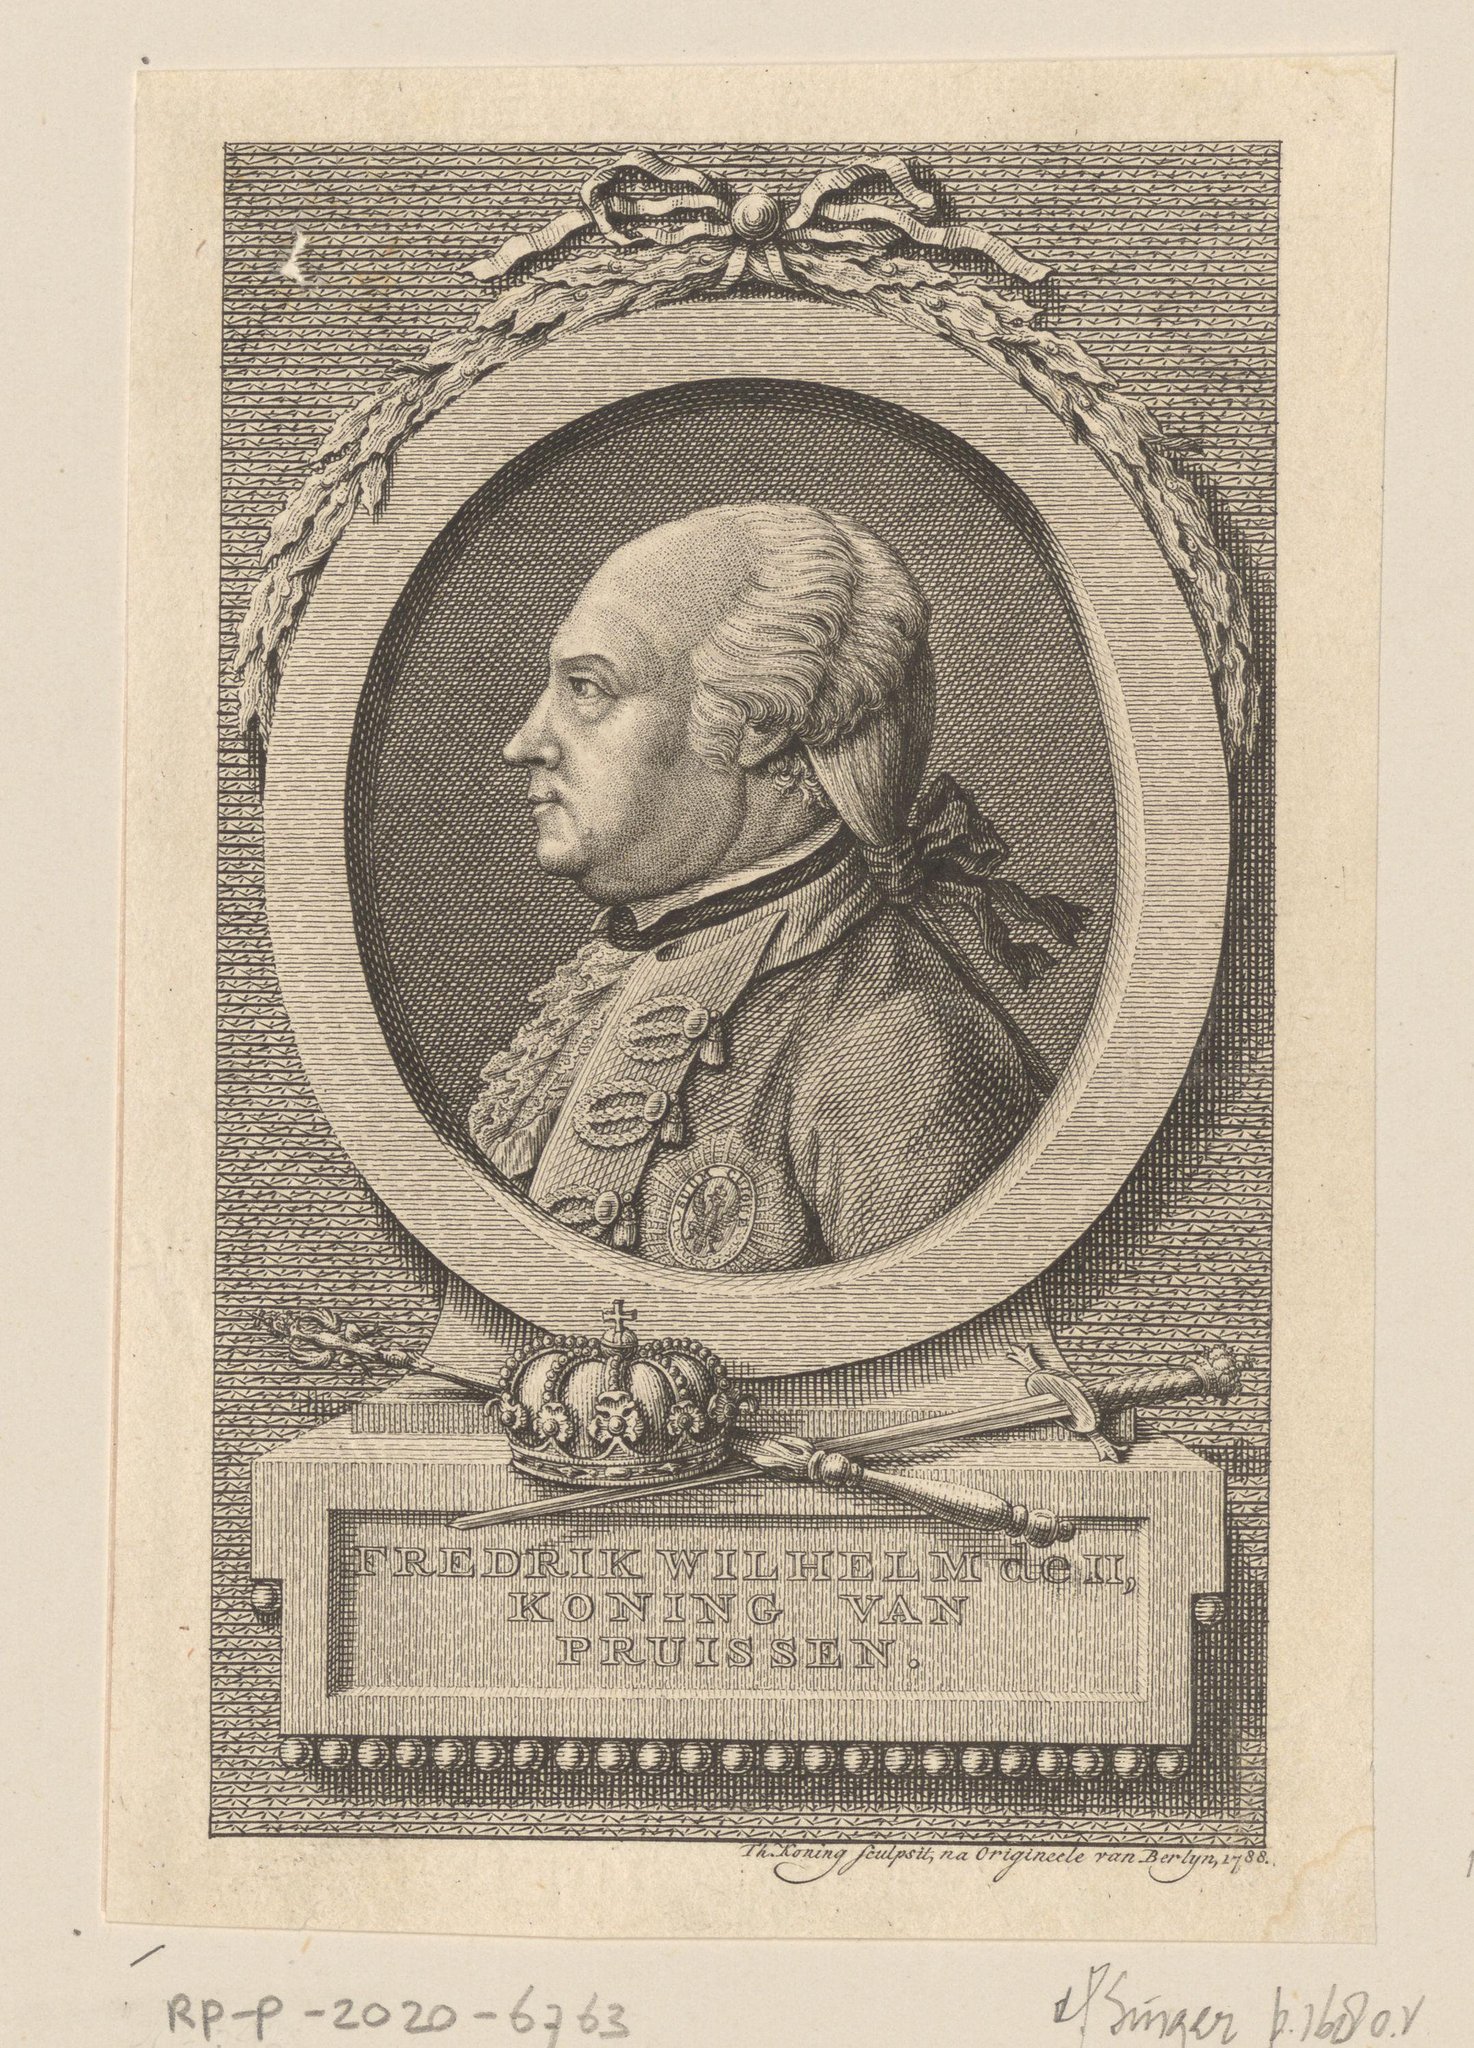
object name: print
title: Portret van Frederik Willem II van Pruisen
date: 1788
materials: paper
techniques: engraving, etching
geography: amsterdam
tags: berlin, frederik willem ii (koning van pruisen), crown (symbol of sovereignty), ornament ~ medallion, historical persons, king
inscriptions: number: ‘No. 392’